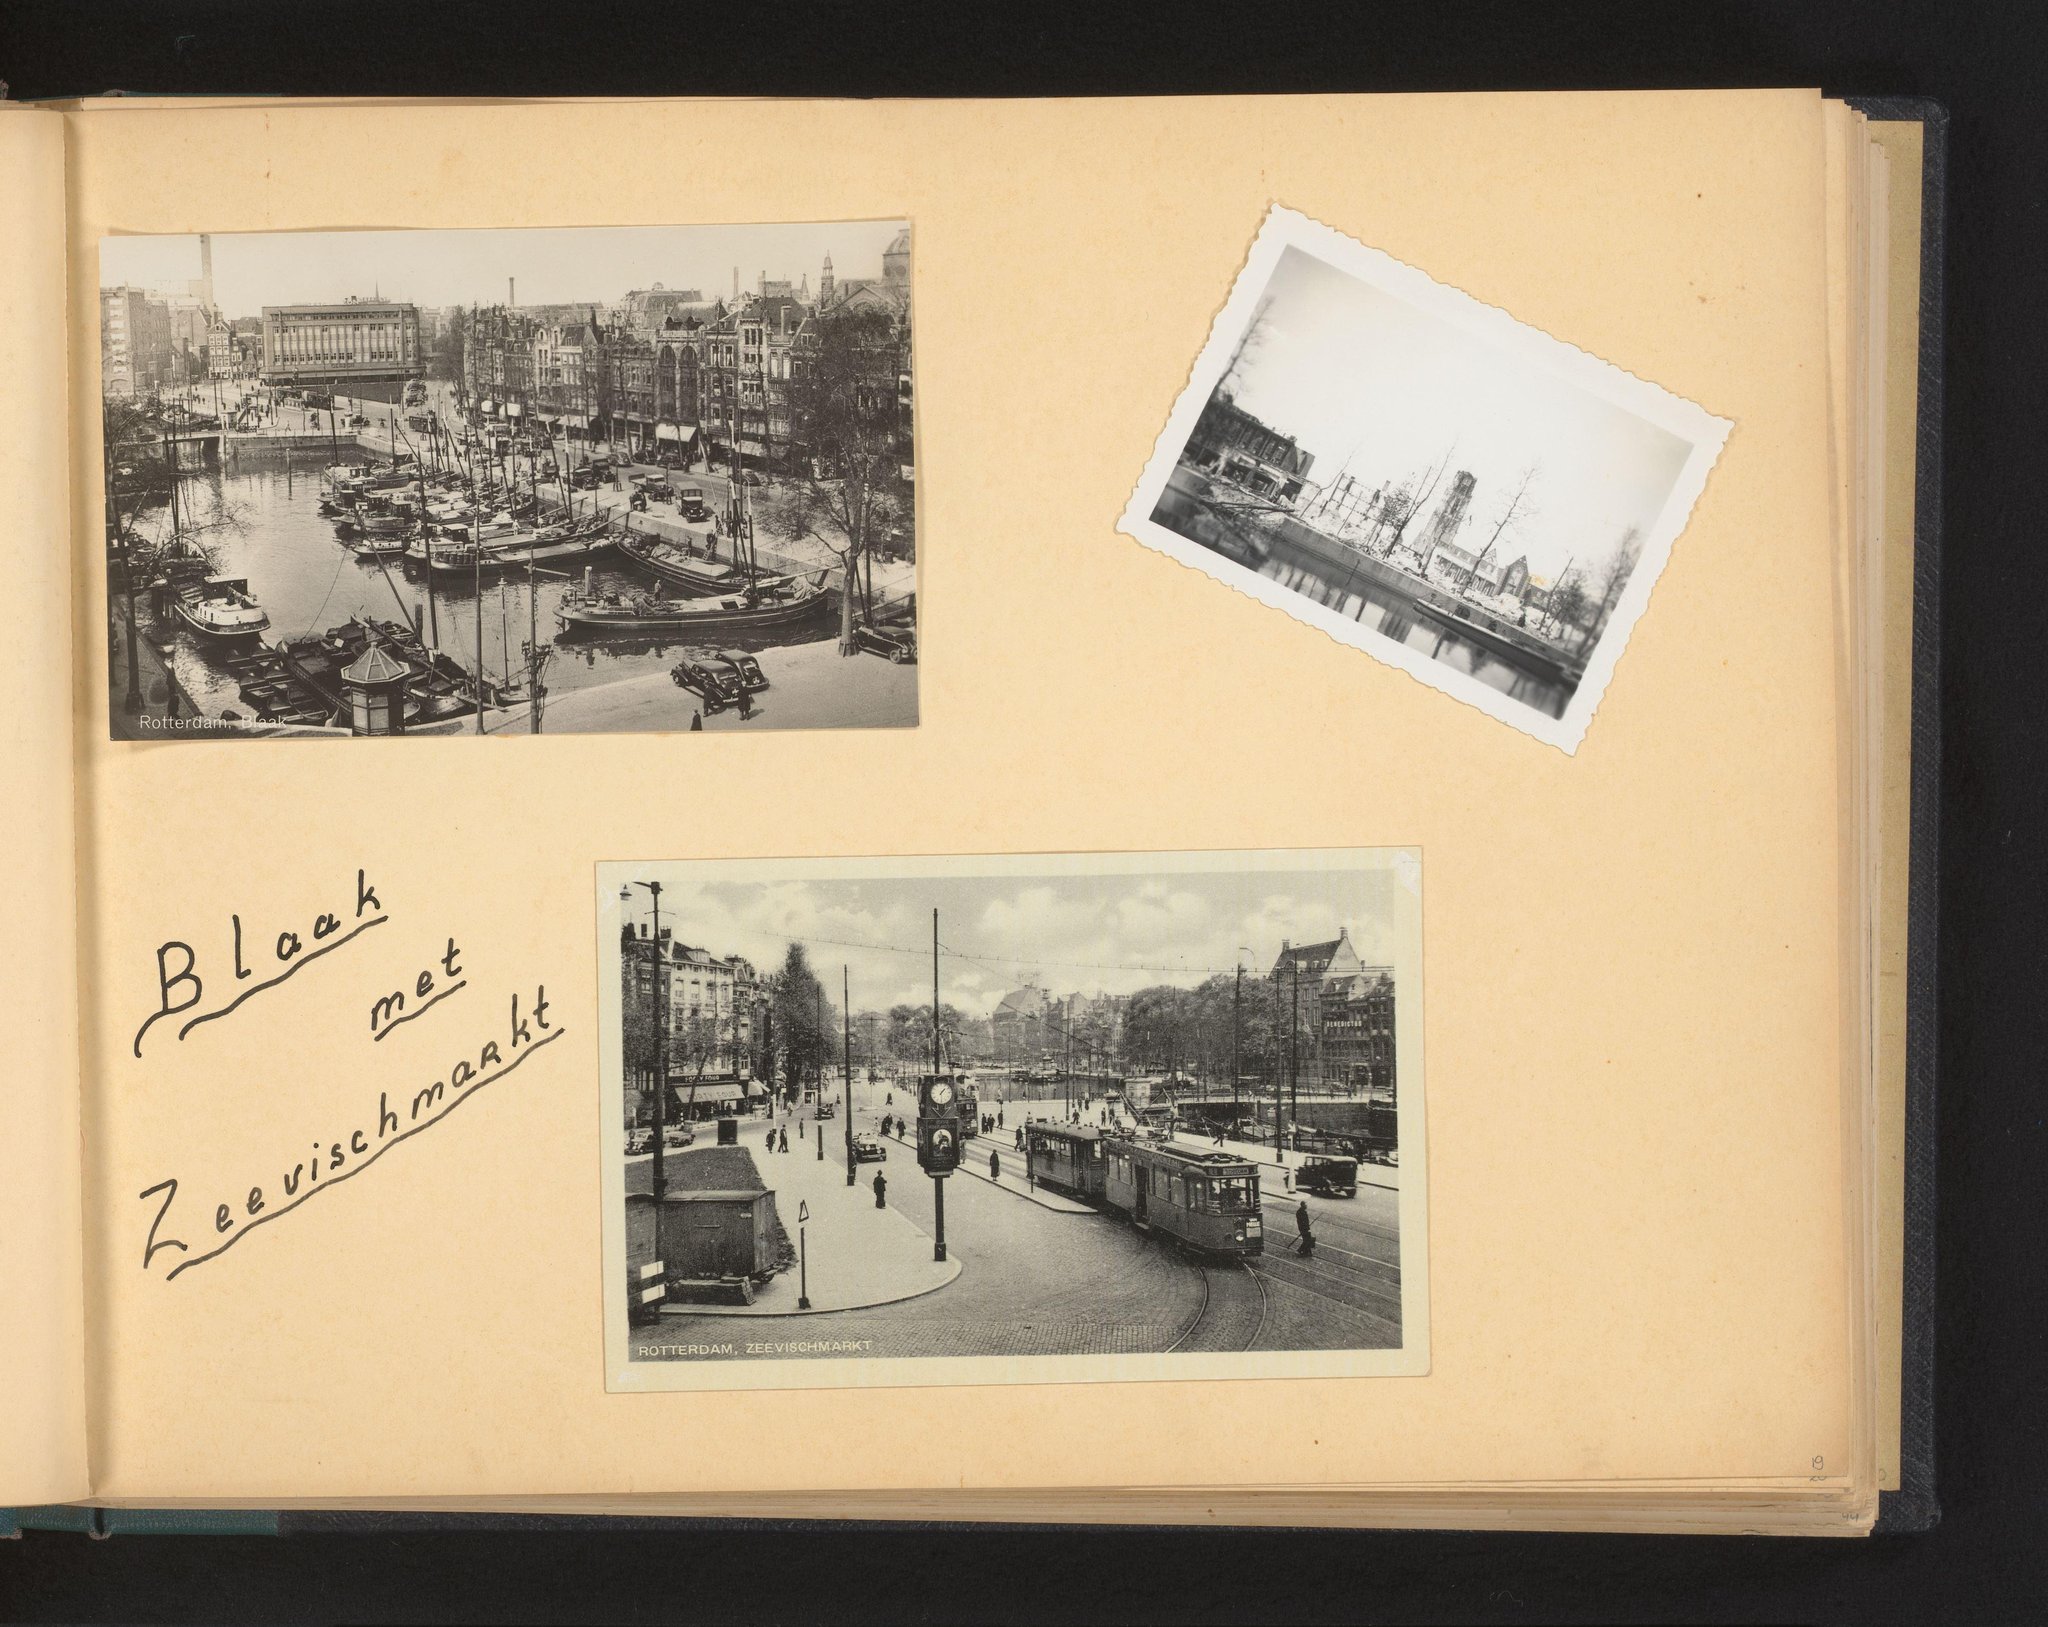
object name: photograph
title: Blaak met Zeevischmarkt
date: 1940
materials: cardboard, photographic support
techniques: photograph, gelatin silver print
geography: rotterdam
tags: non-combatants ~ war, devastated, ruined place or city (~ warfare), rotterdam, rotterdam blitz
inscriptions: inscription: ‘Blaak met Zeevischmarkt’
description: Albumblad met twee prentbriefkaarten en een foto van de Blaak en vismarkt, voor en na het bombardement van Rotterdam. Onderdeel van het fotoalbum over de verwoestingen van Nederlandse steden en infrastructuur in het begin van de Tweede Wereldoorlog.